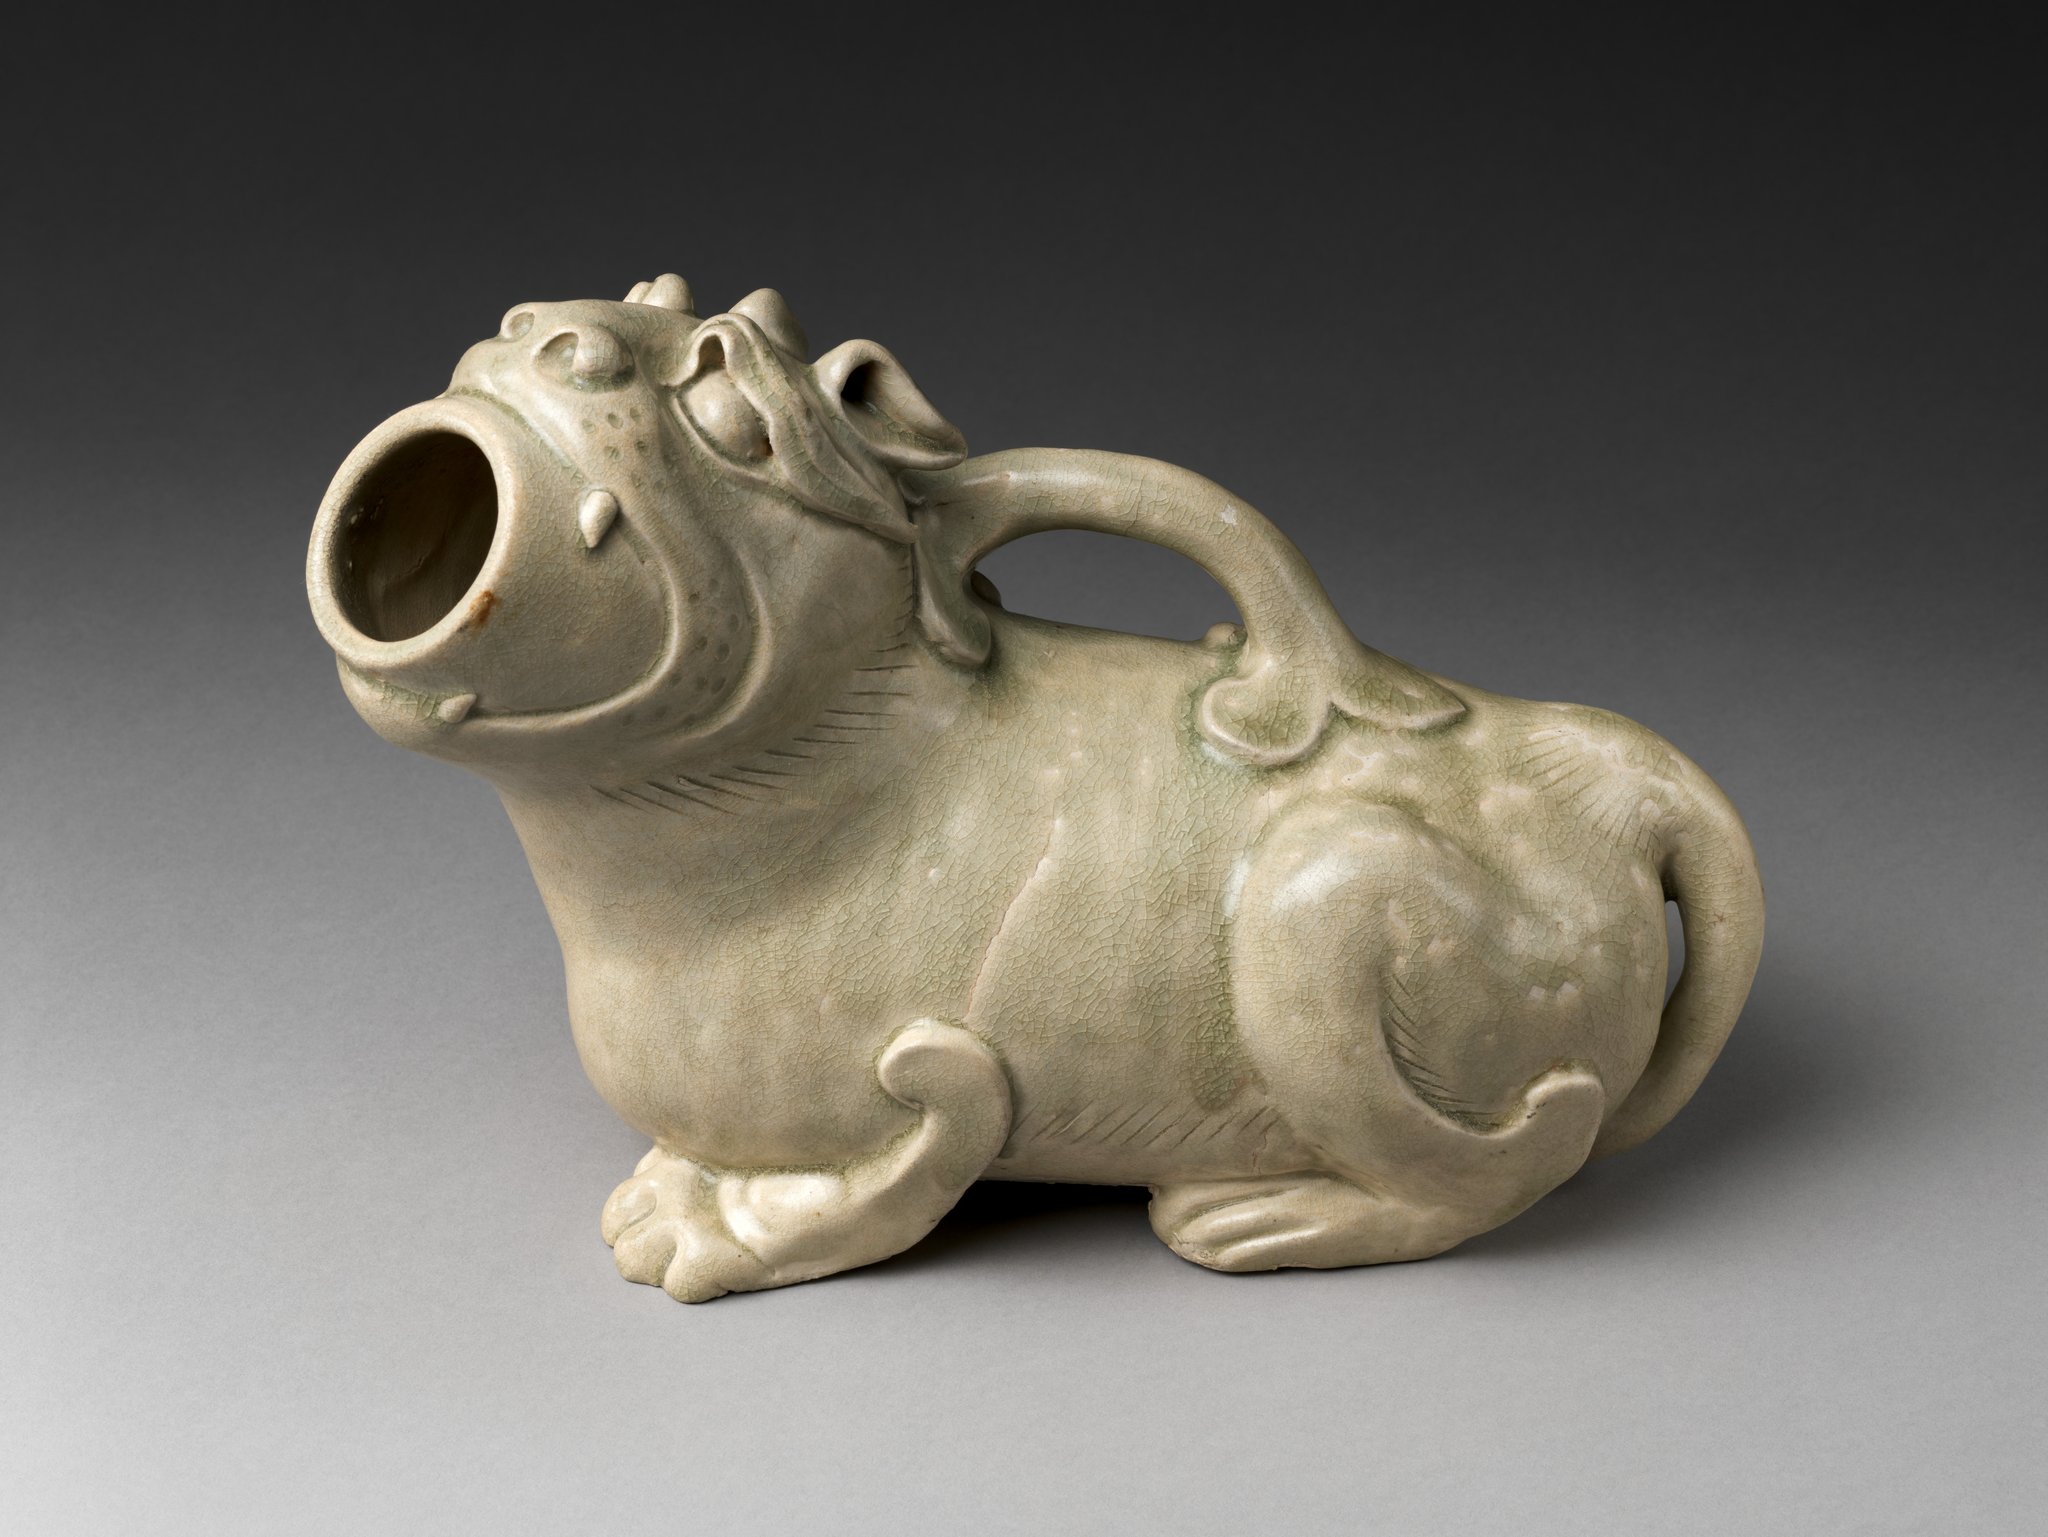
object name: vessel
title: Vessel in shape of a crouching tiger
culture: chinese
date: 201-500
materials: ceramic glaze, glaze, stoneware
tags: tigers